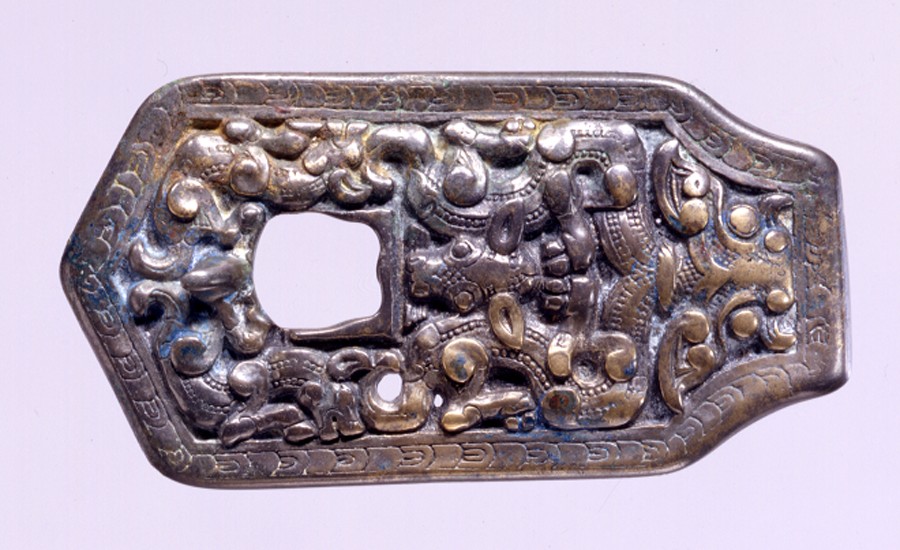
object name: belt buckle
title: Belt Buckle with Animal Motifs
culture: northwest chinese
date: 500-301 BCE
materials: bronze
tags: animals